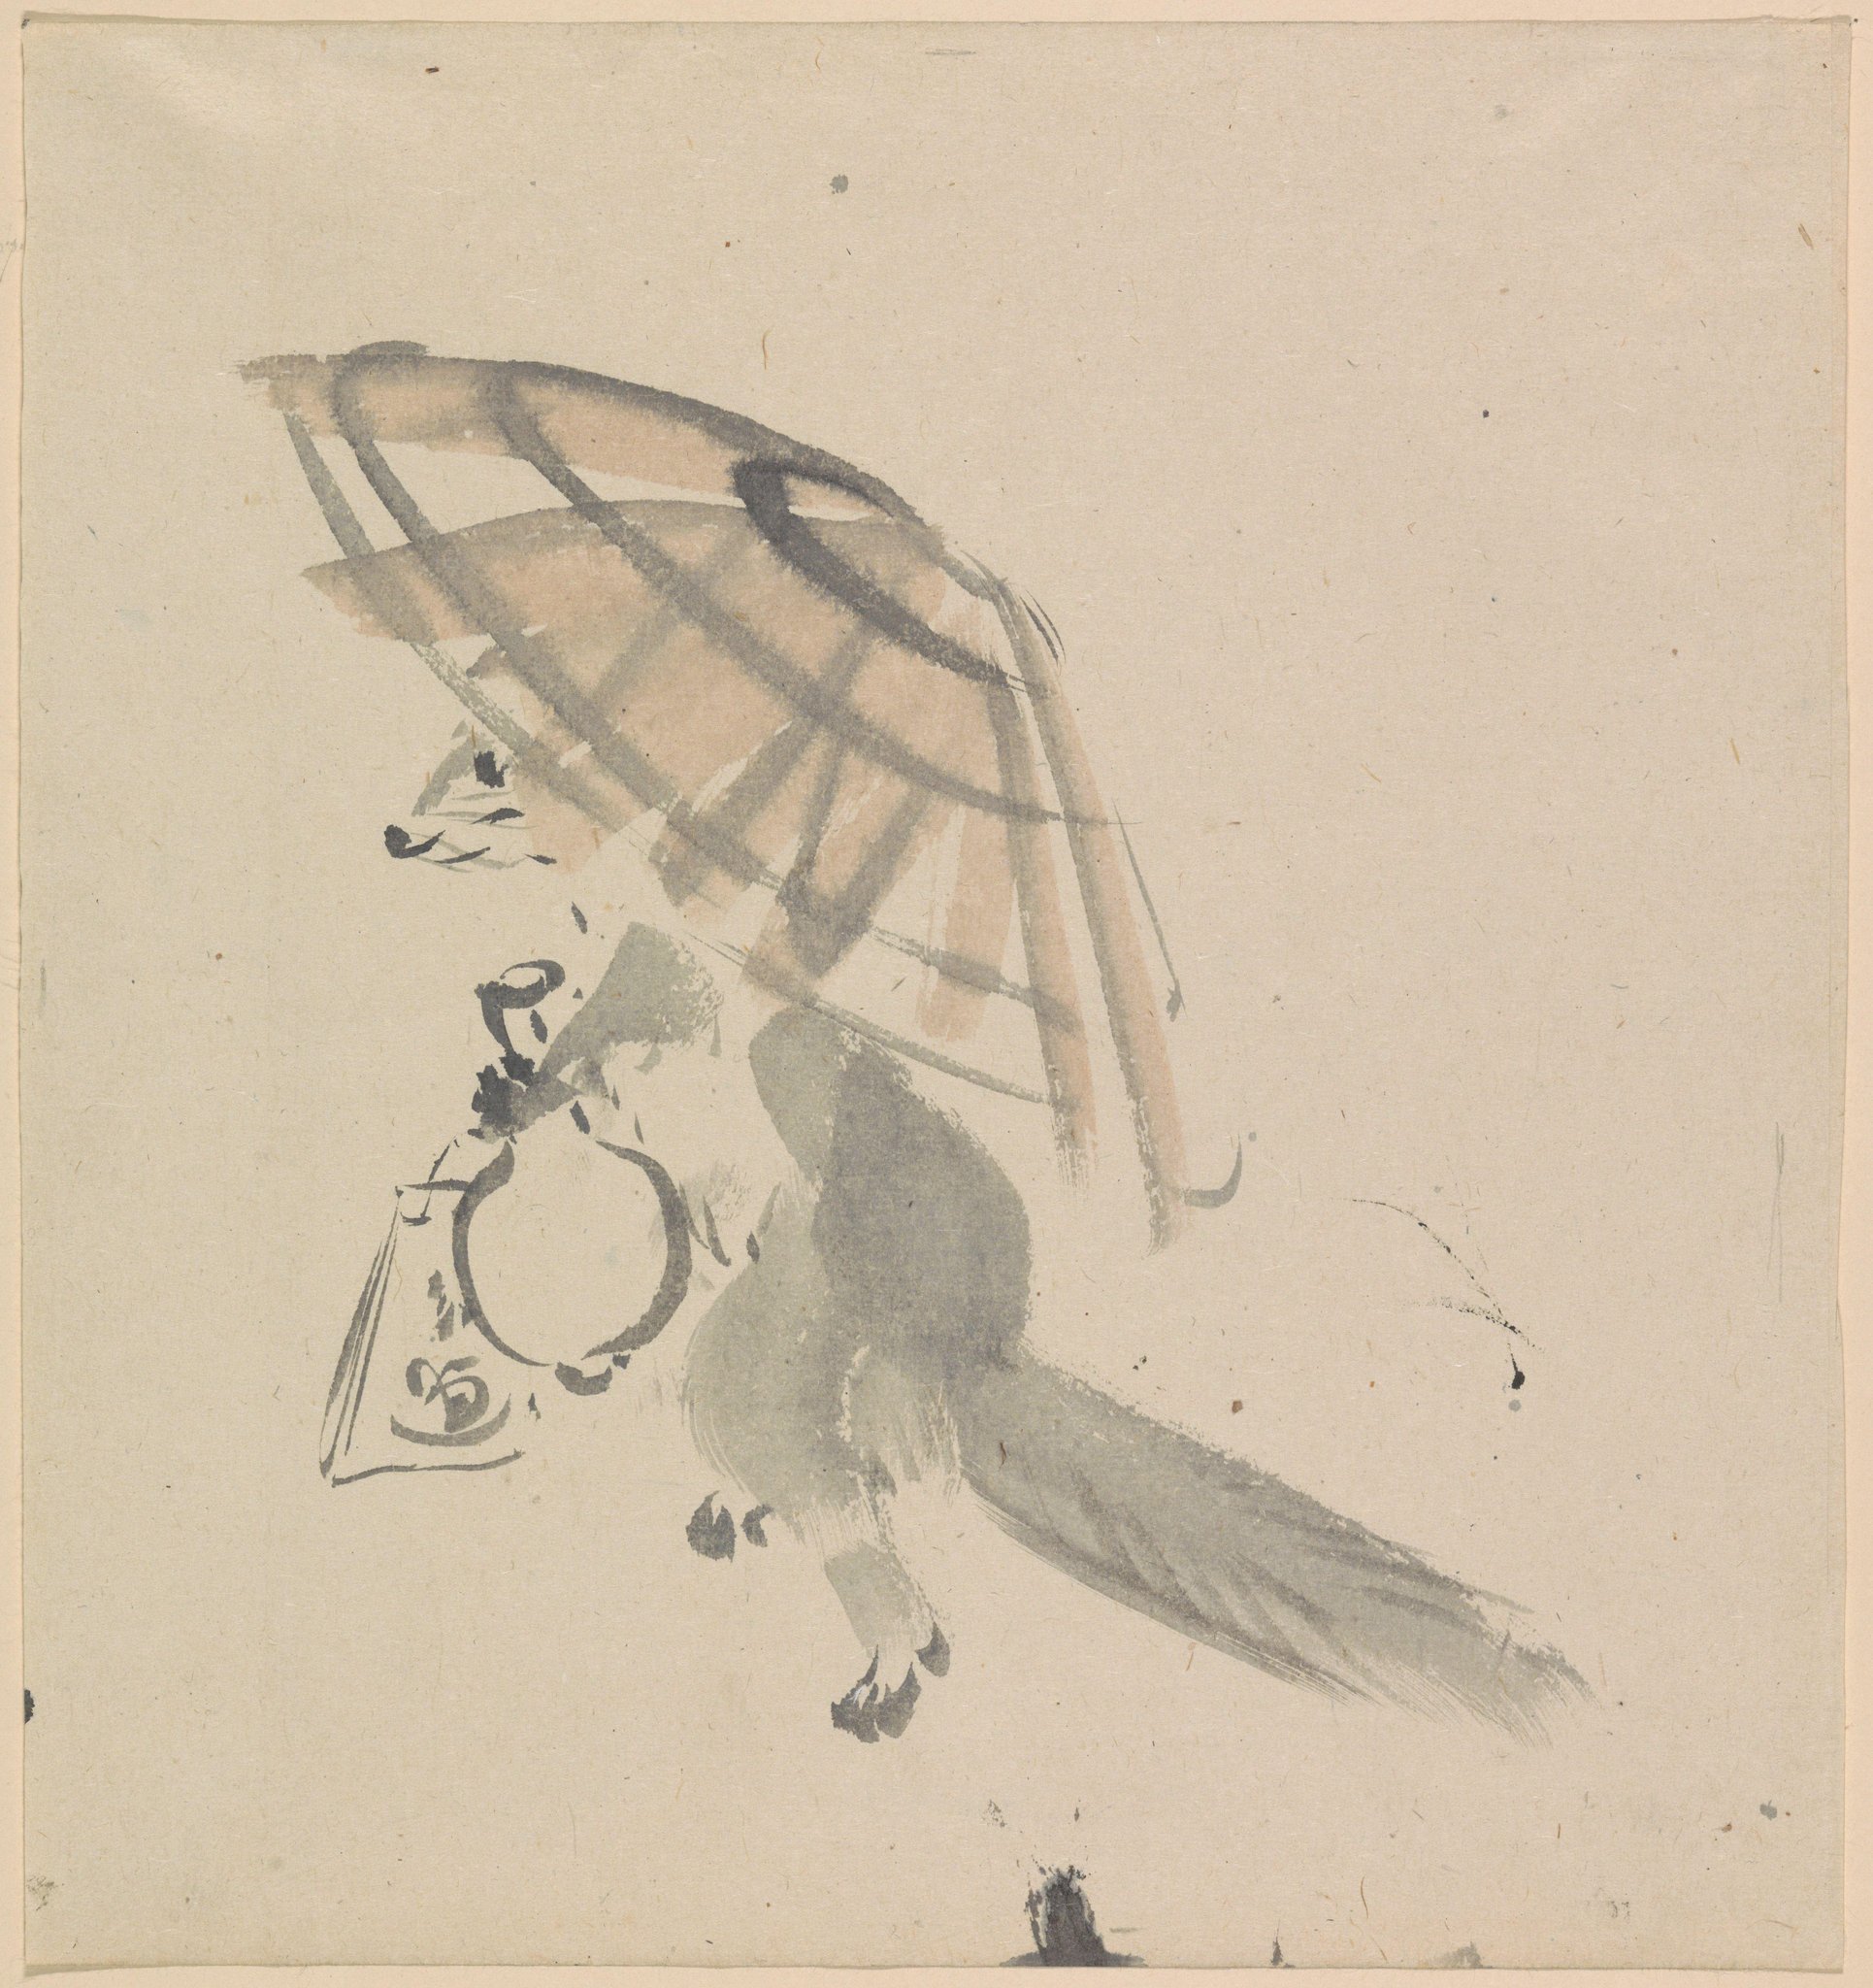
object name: watercolor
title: Vos met karaf en parasol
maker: kawanabe kyôsai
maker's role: draughtsman, print maker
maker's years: 1831-1889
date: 1841-1889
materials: paper, watercolor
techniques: brush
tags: pilgrim(s)